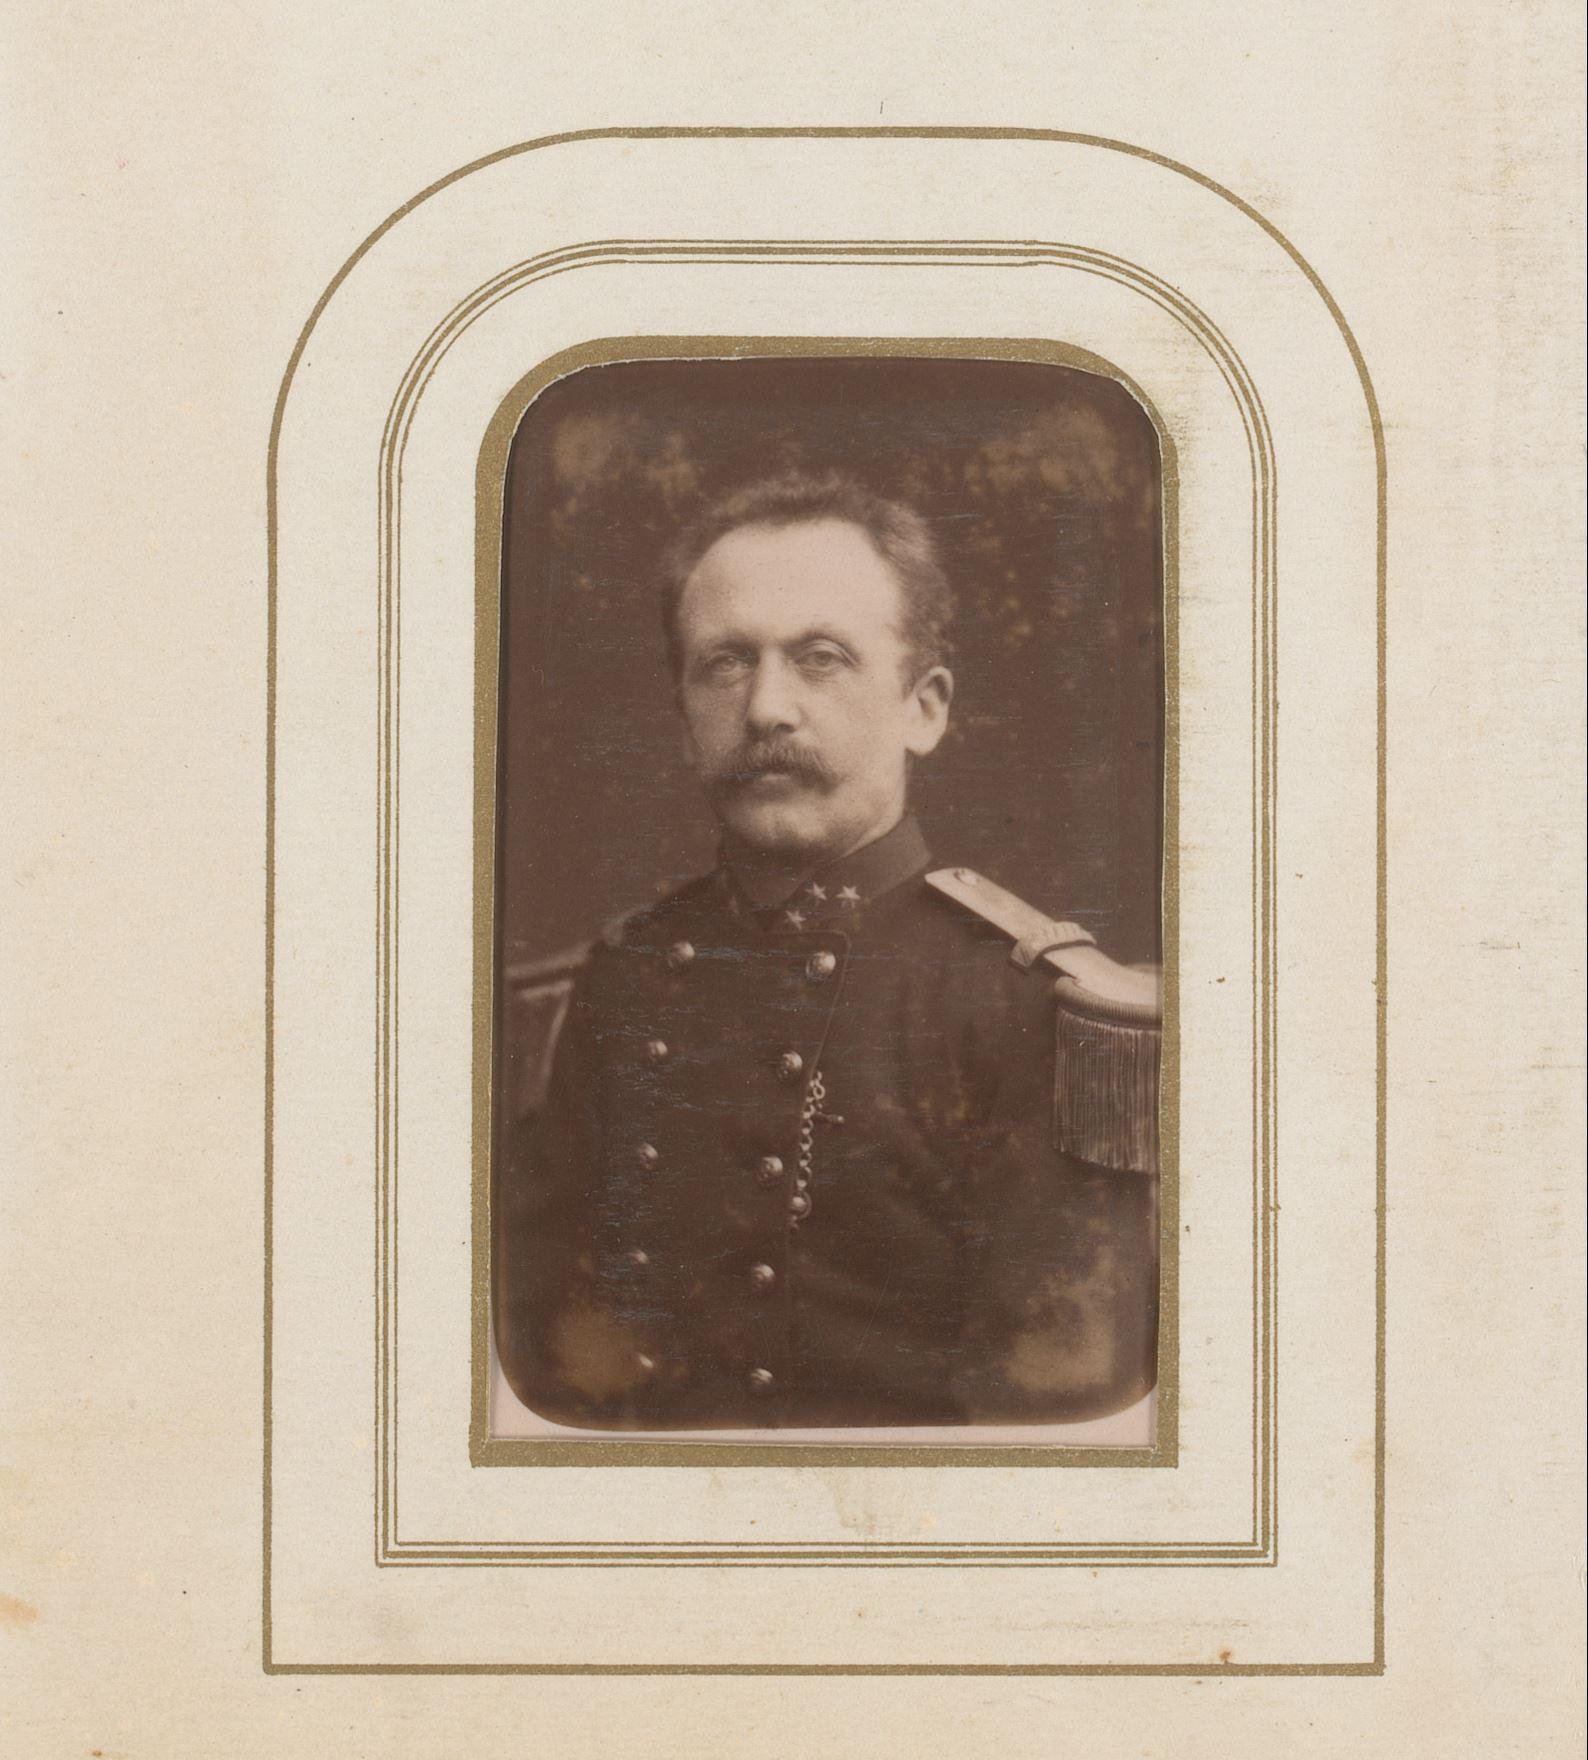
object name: semi enamel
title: Portret van een man met snor in uniform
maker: Anonymous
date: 1880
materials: cardboard, celluloid, photographic support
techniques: albumen print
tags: historical persons, (military) uniforms, beard